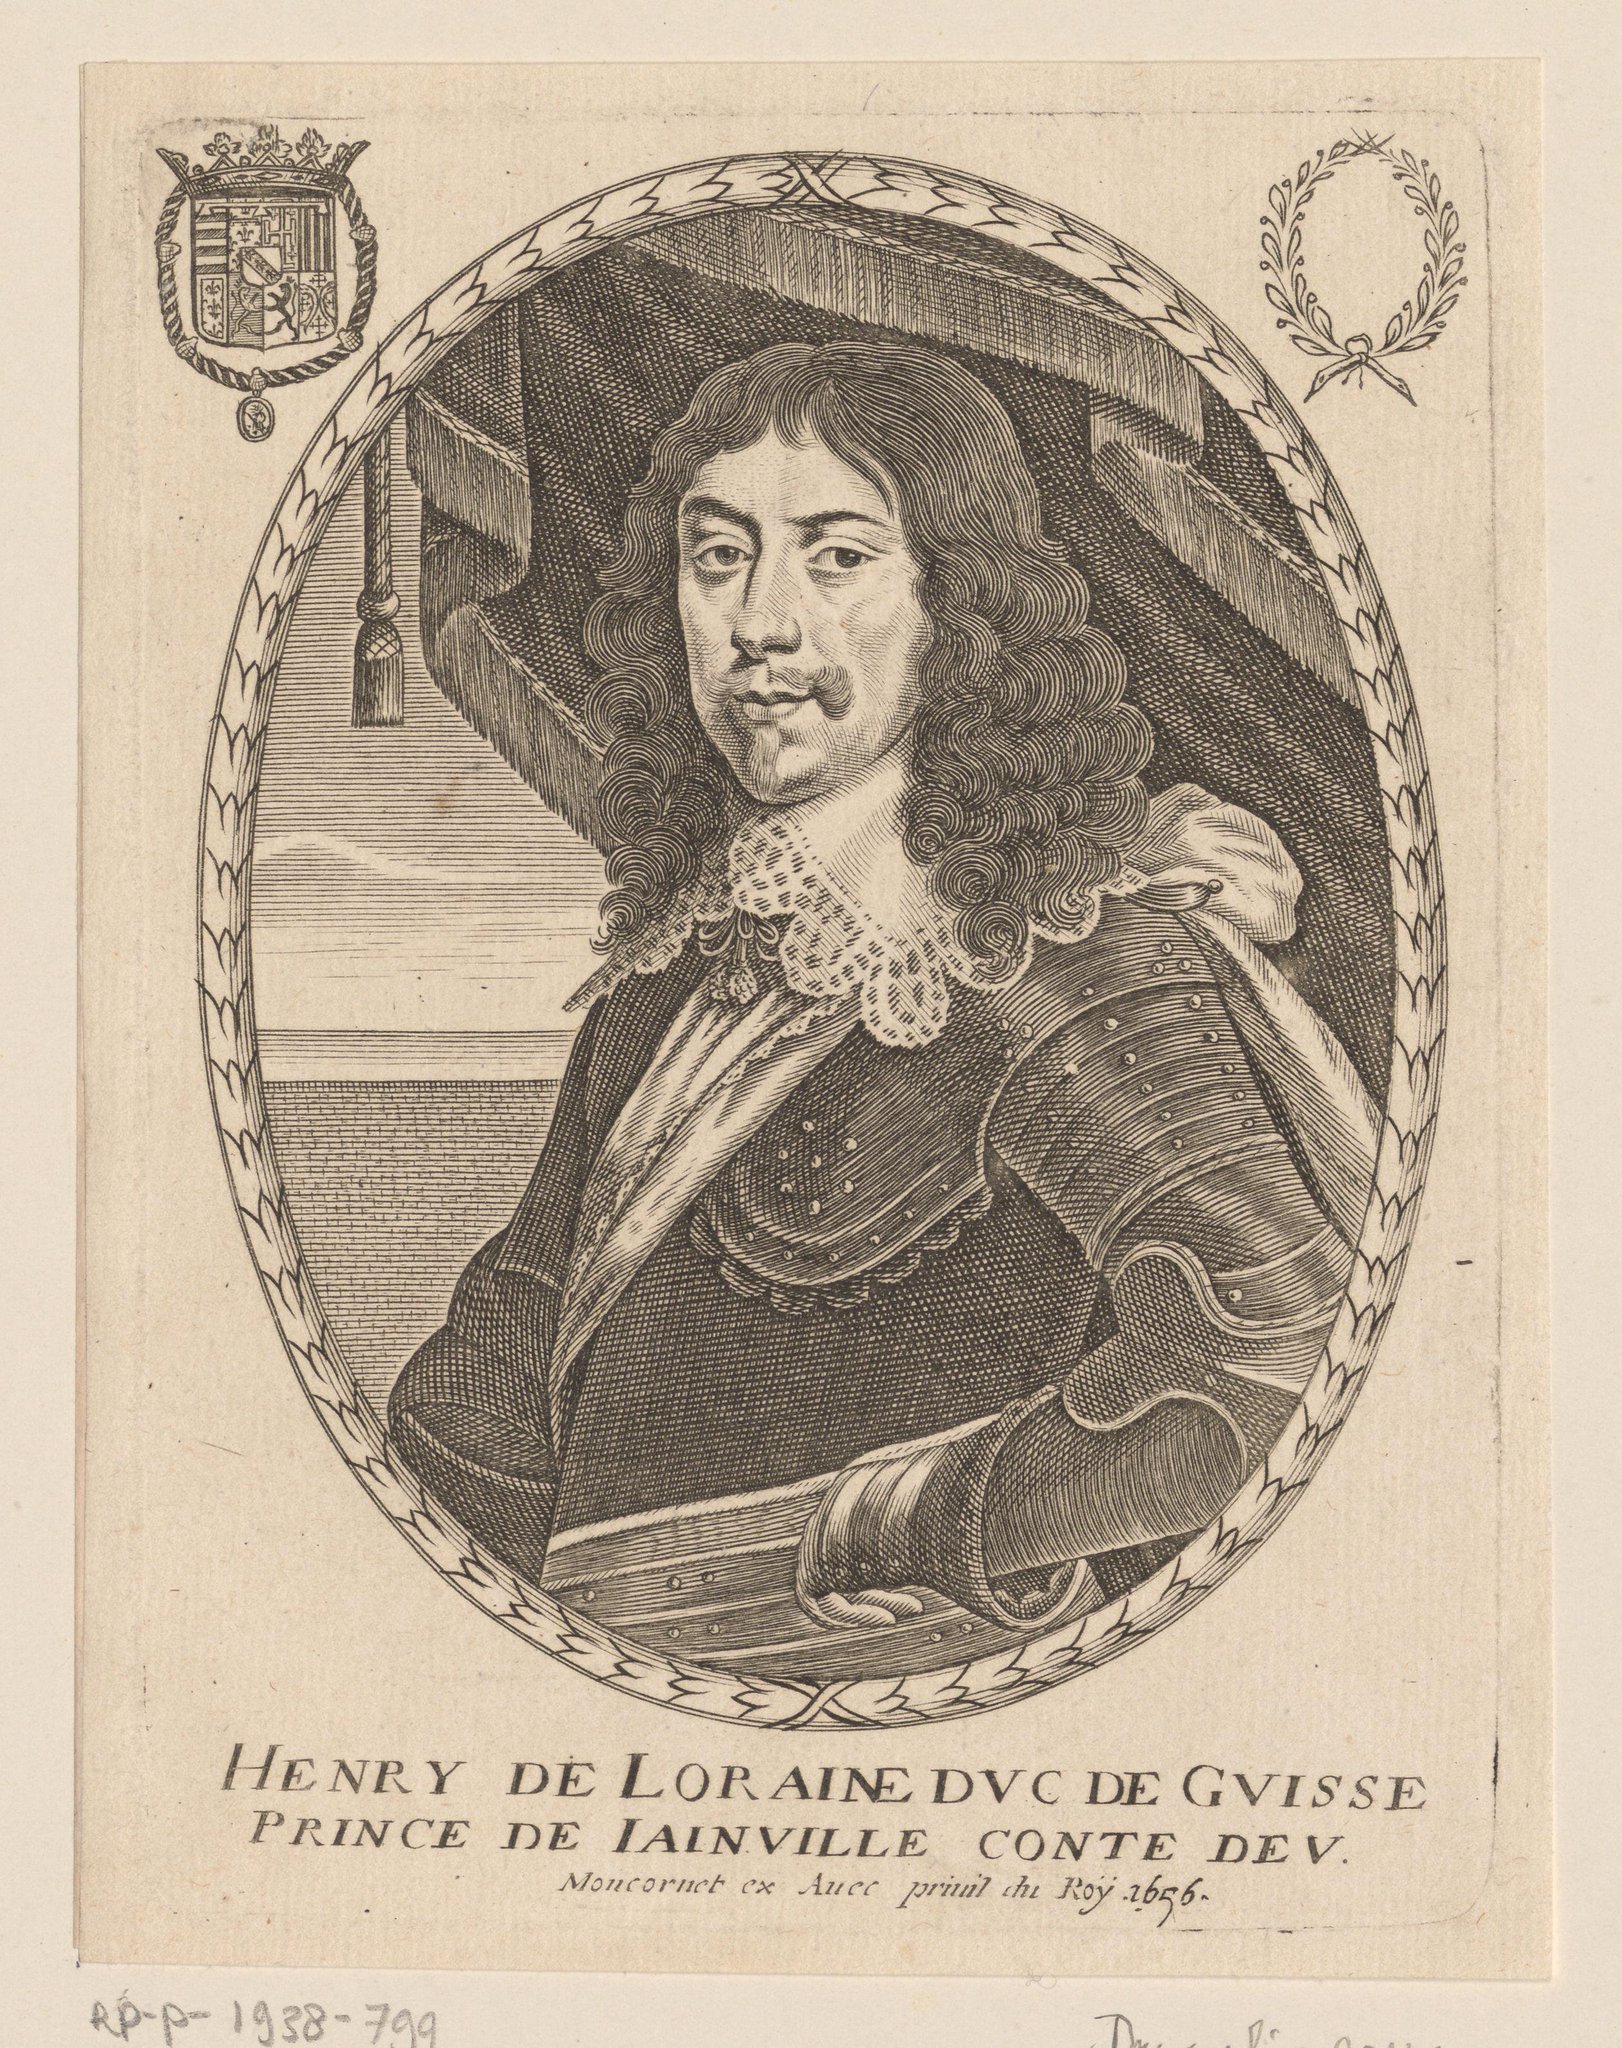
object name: print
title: Portret van Hendrik II de Lorraine, hertog van Guise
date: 1656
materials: paper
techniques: engraving, etching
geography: paris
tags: paris, historical persons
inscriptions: collector's mark: Lugt 2228